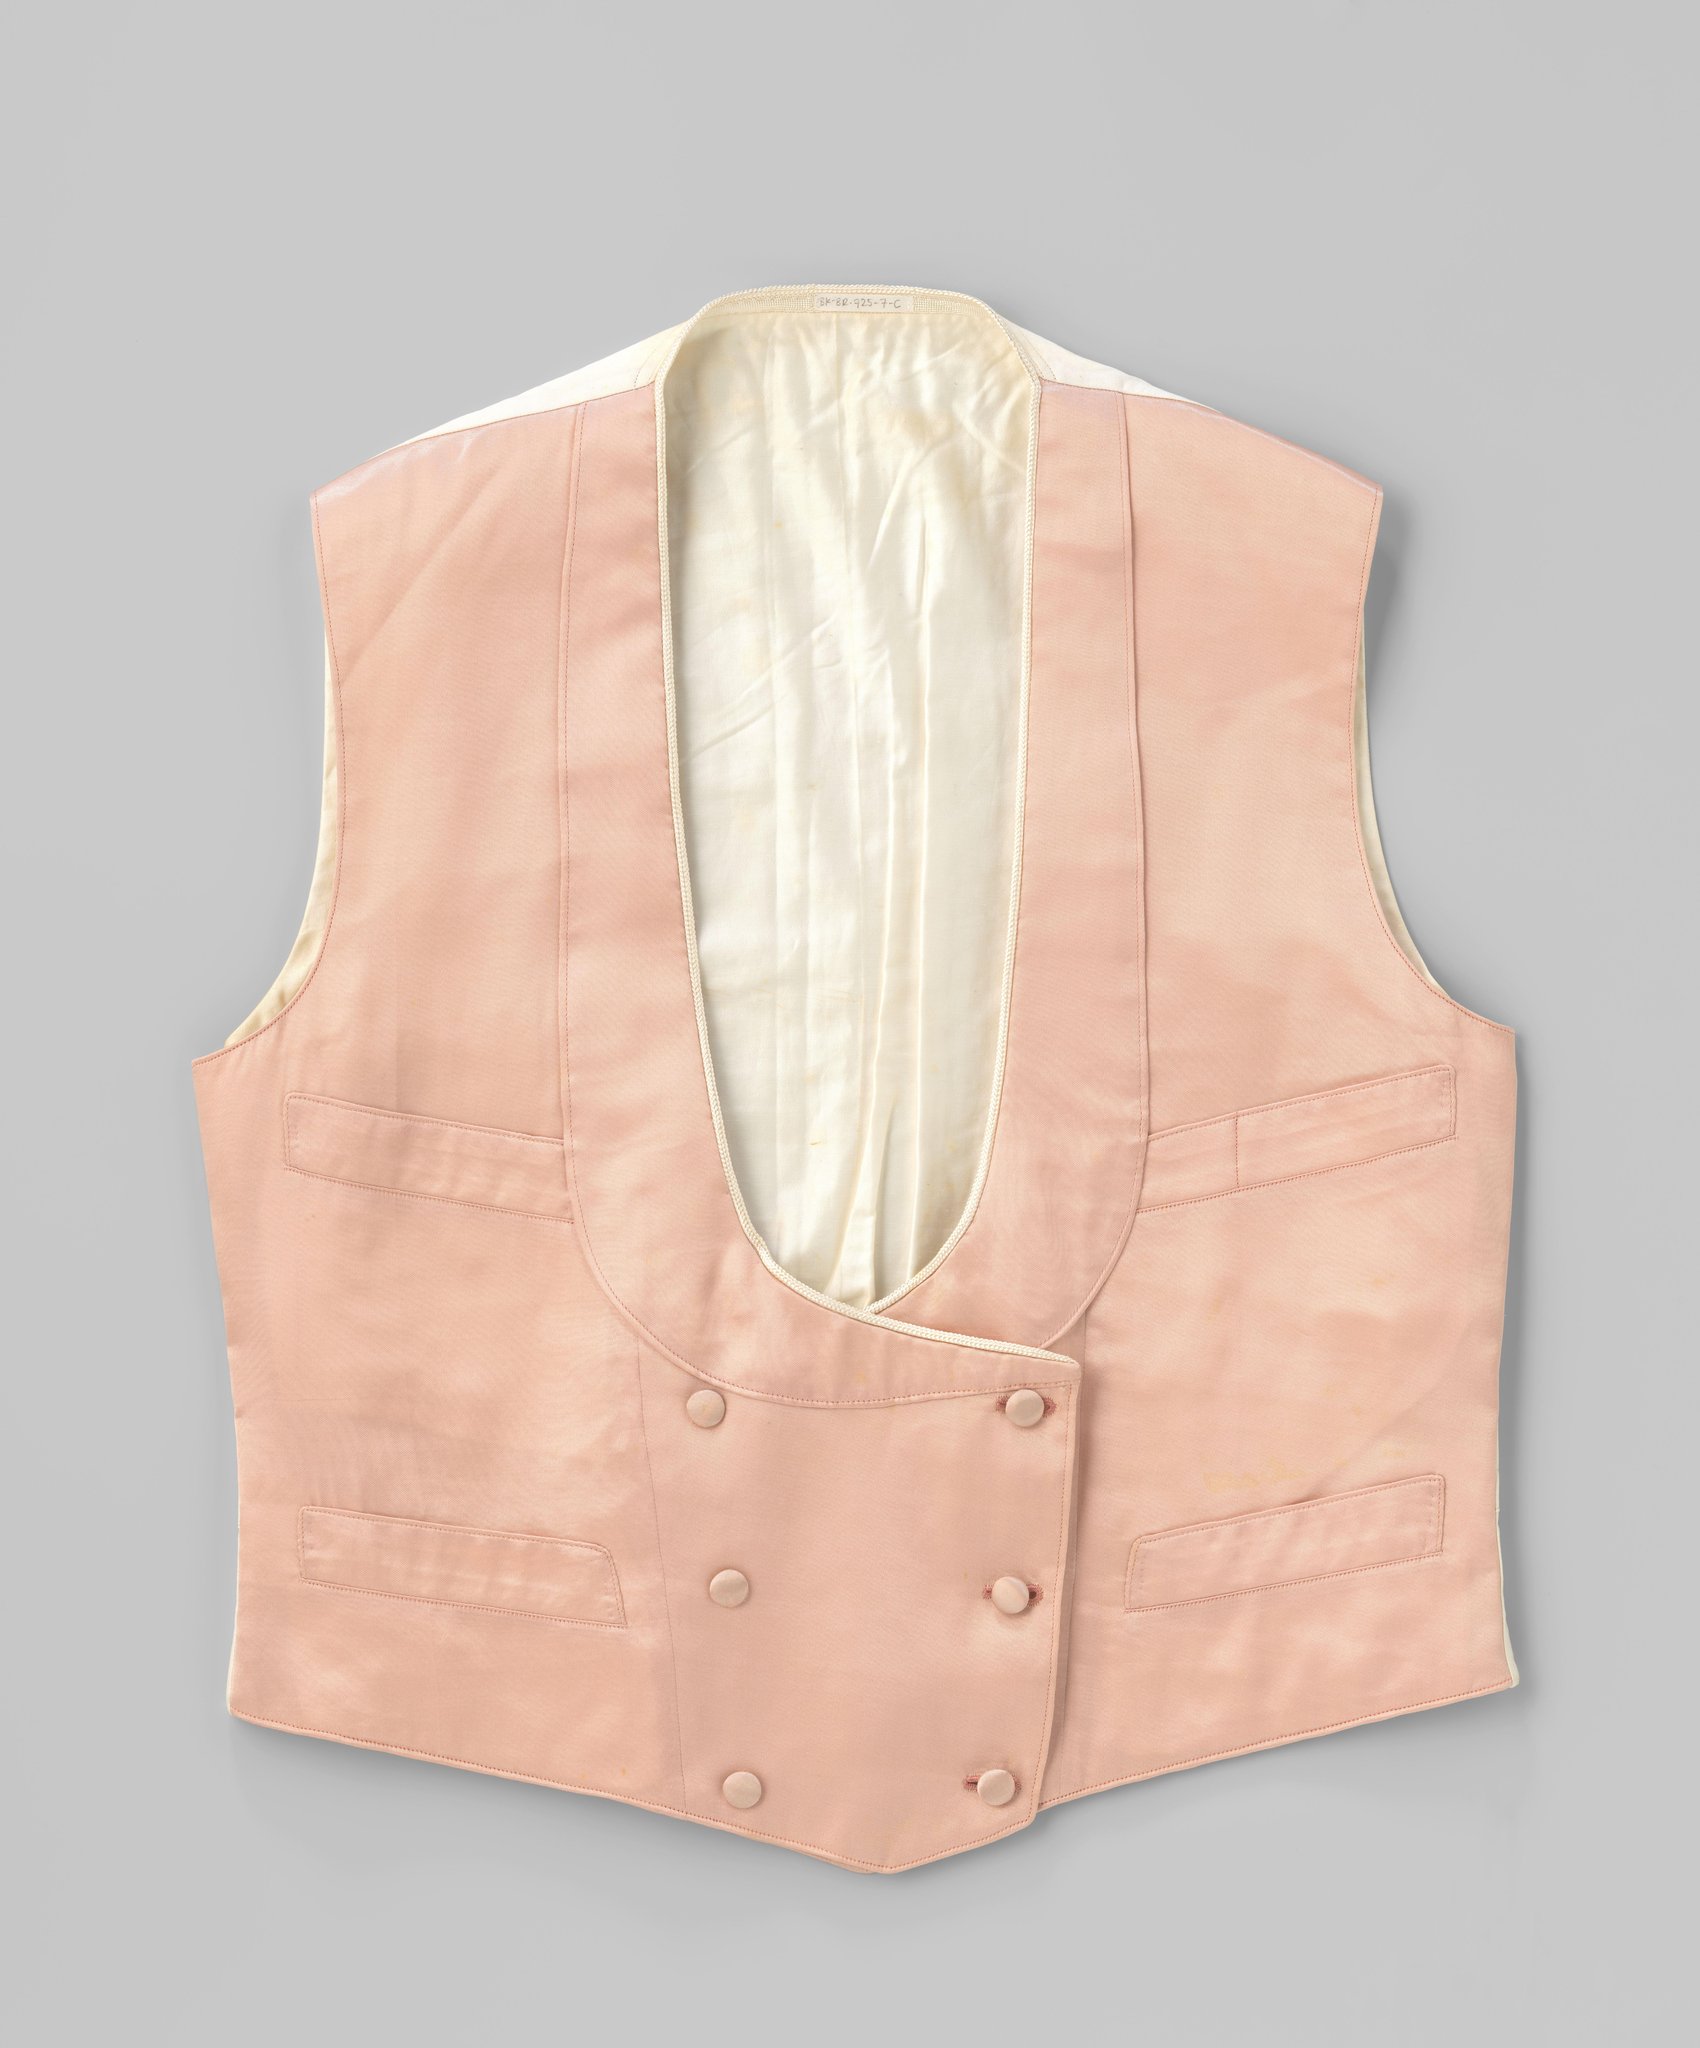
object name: vest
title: Waistcoat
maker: a. chrobolka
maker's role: kleermaker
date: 1910-1930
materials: cotton, textile, silk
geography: the hague